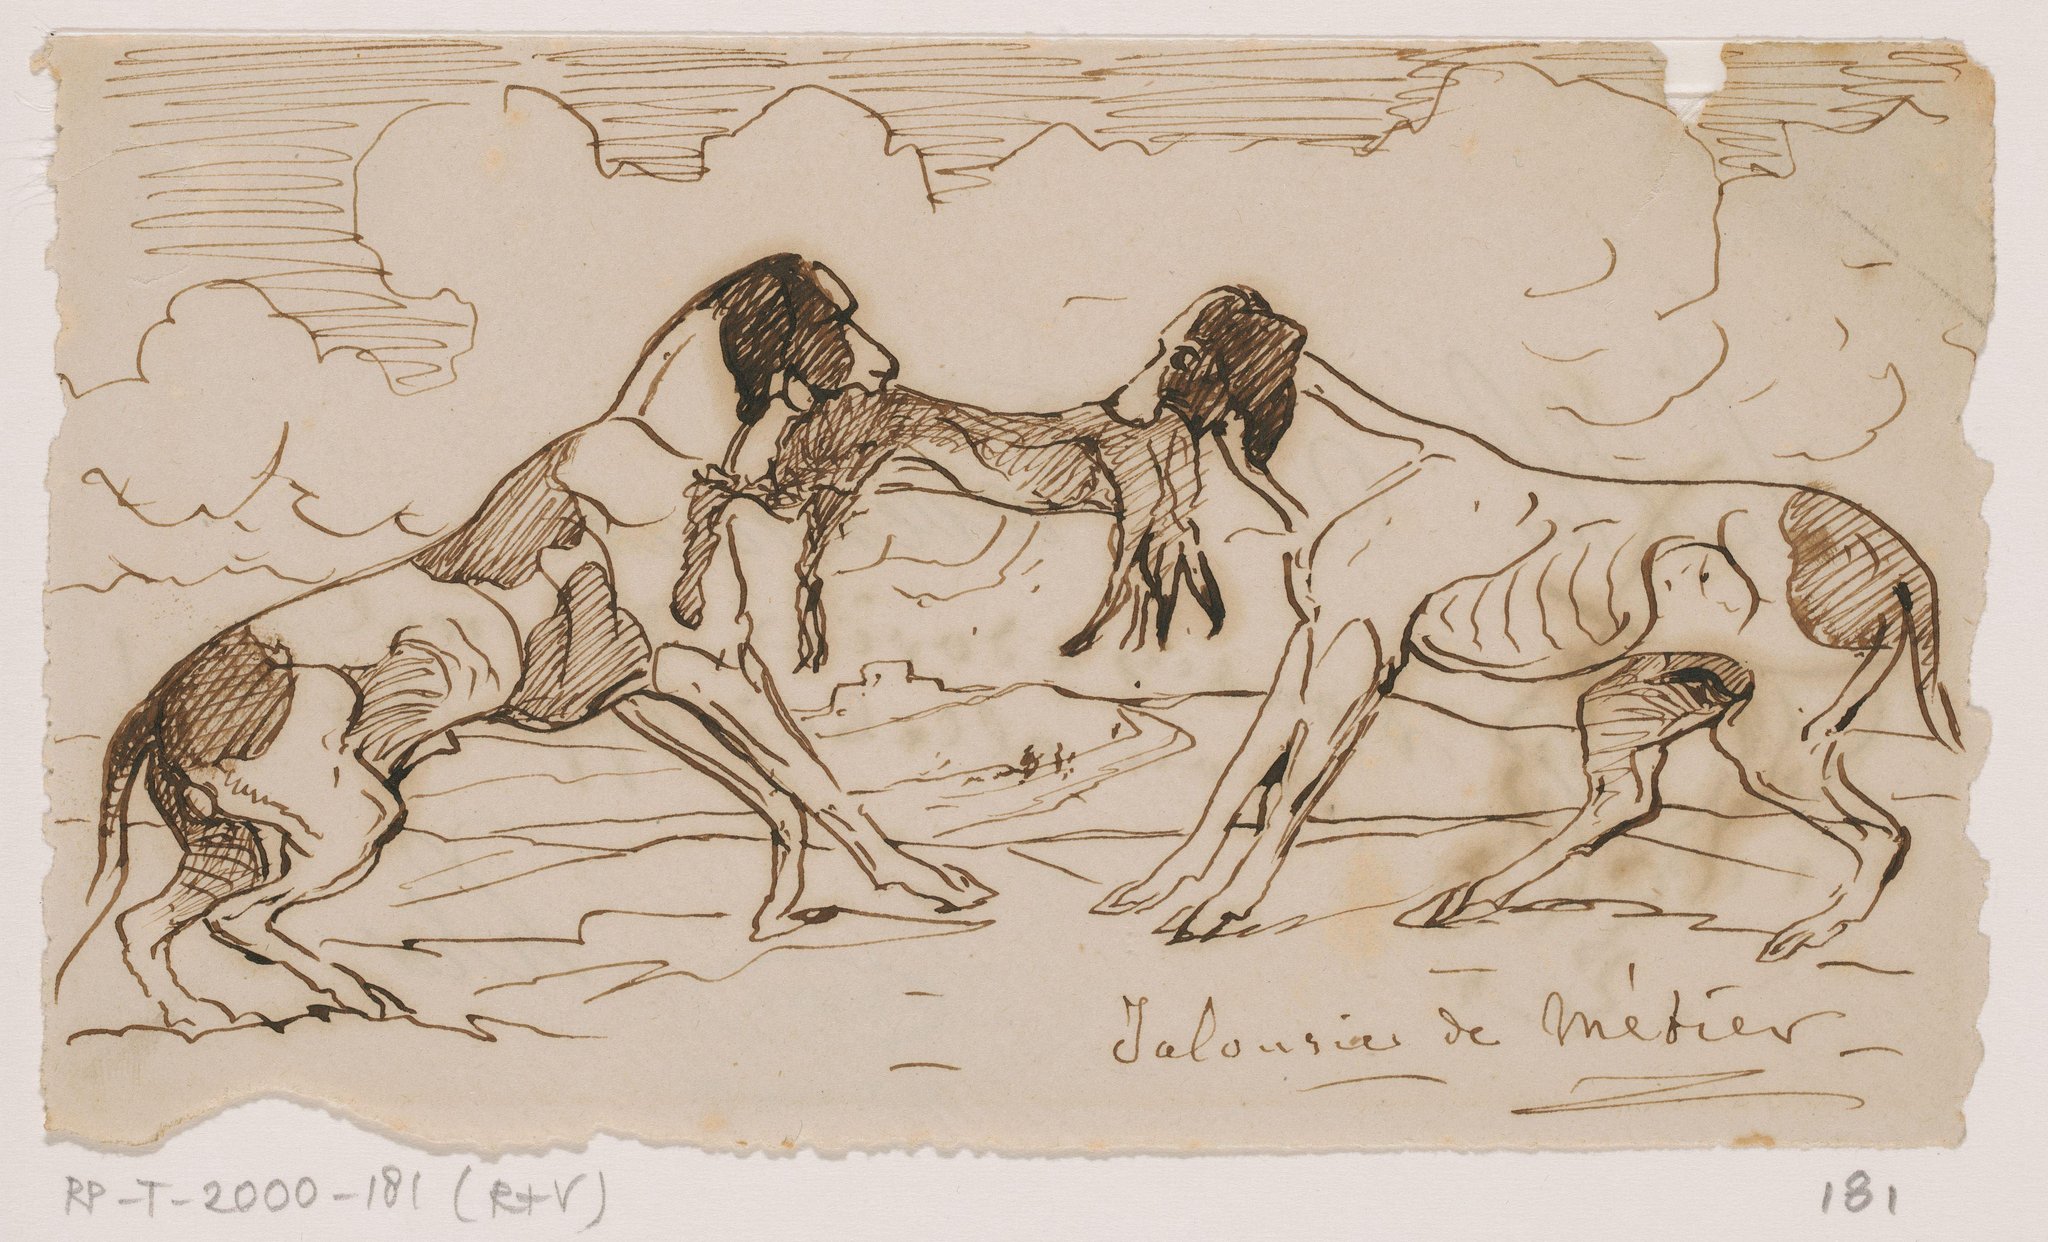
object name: drawing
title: Twee jachthonden met een haas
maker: johannes tavenraat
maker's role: draughtsman, painter, print maker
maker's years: 1809-1881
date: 1840-1880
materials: ink, paper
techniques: pen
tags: hunting dogs, hare-hunting, rabbit-hunting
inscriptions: annotation: ‘Jalousie de métier’